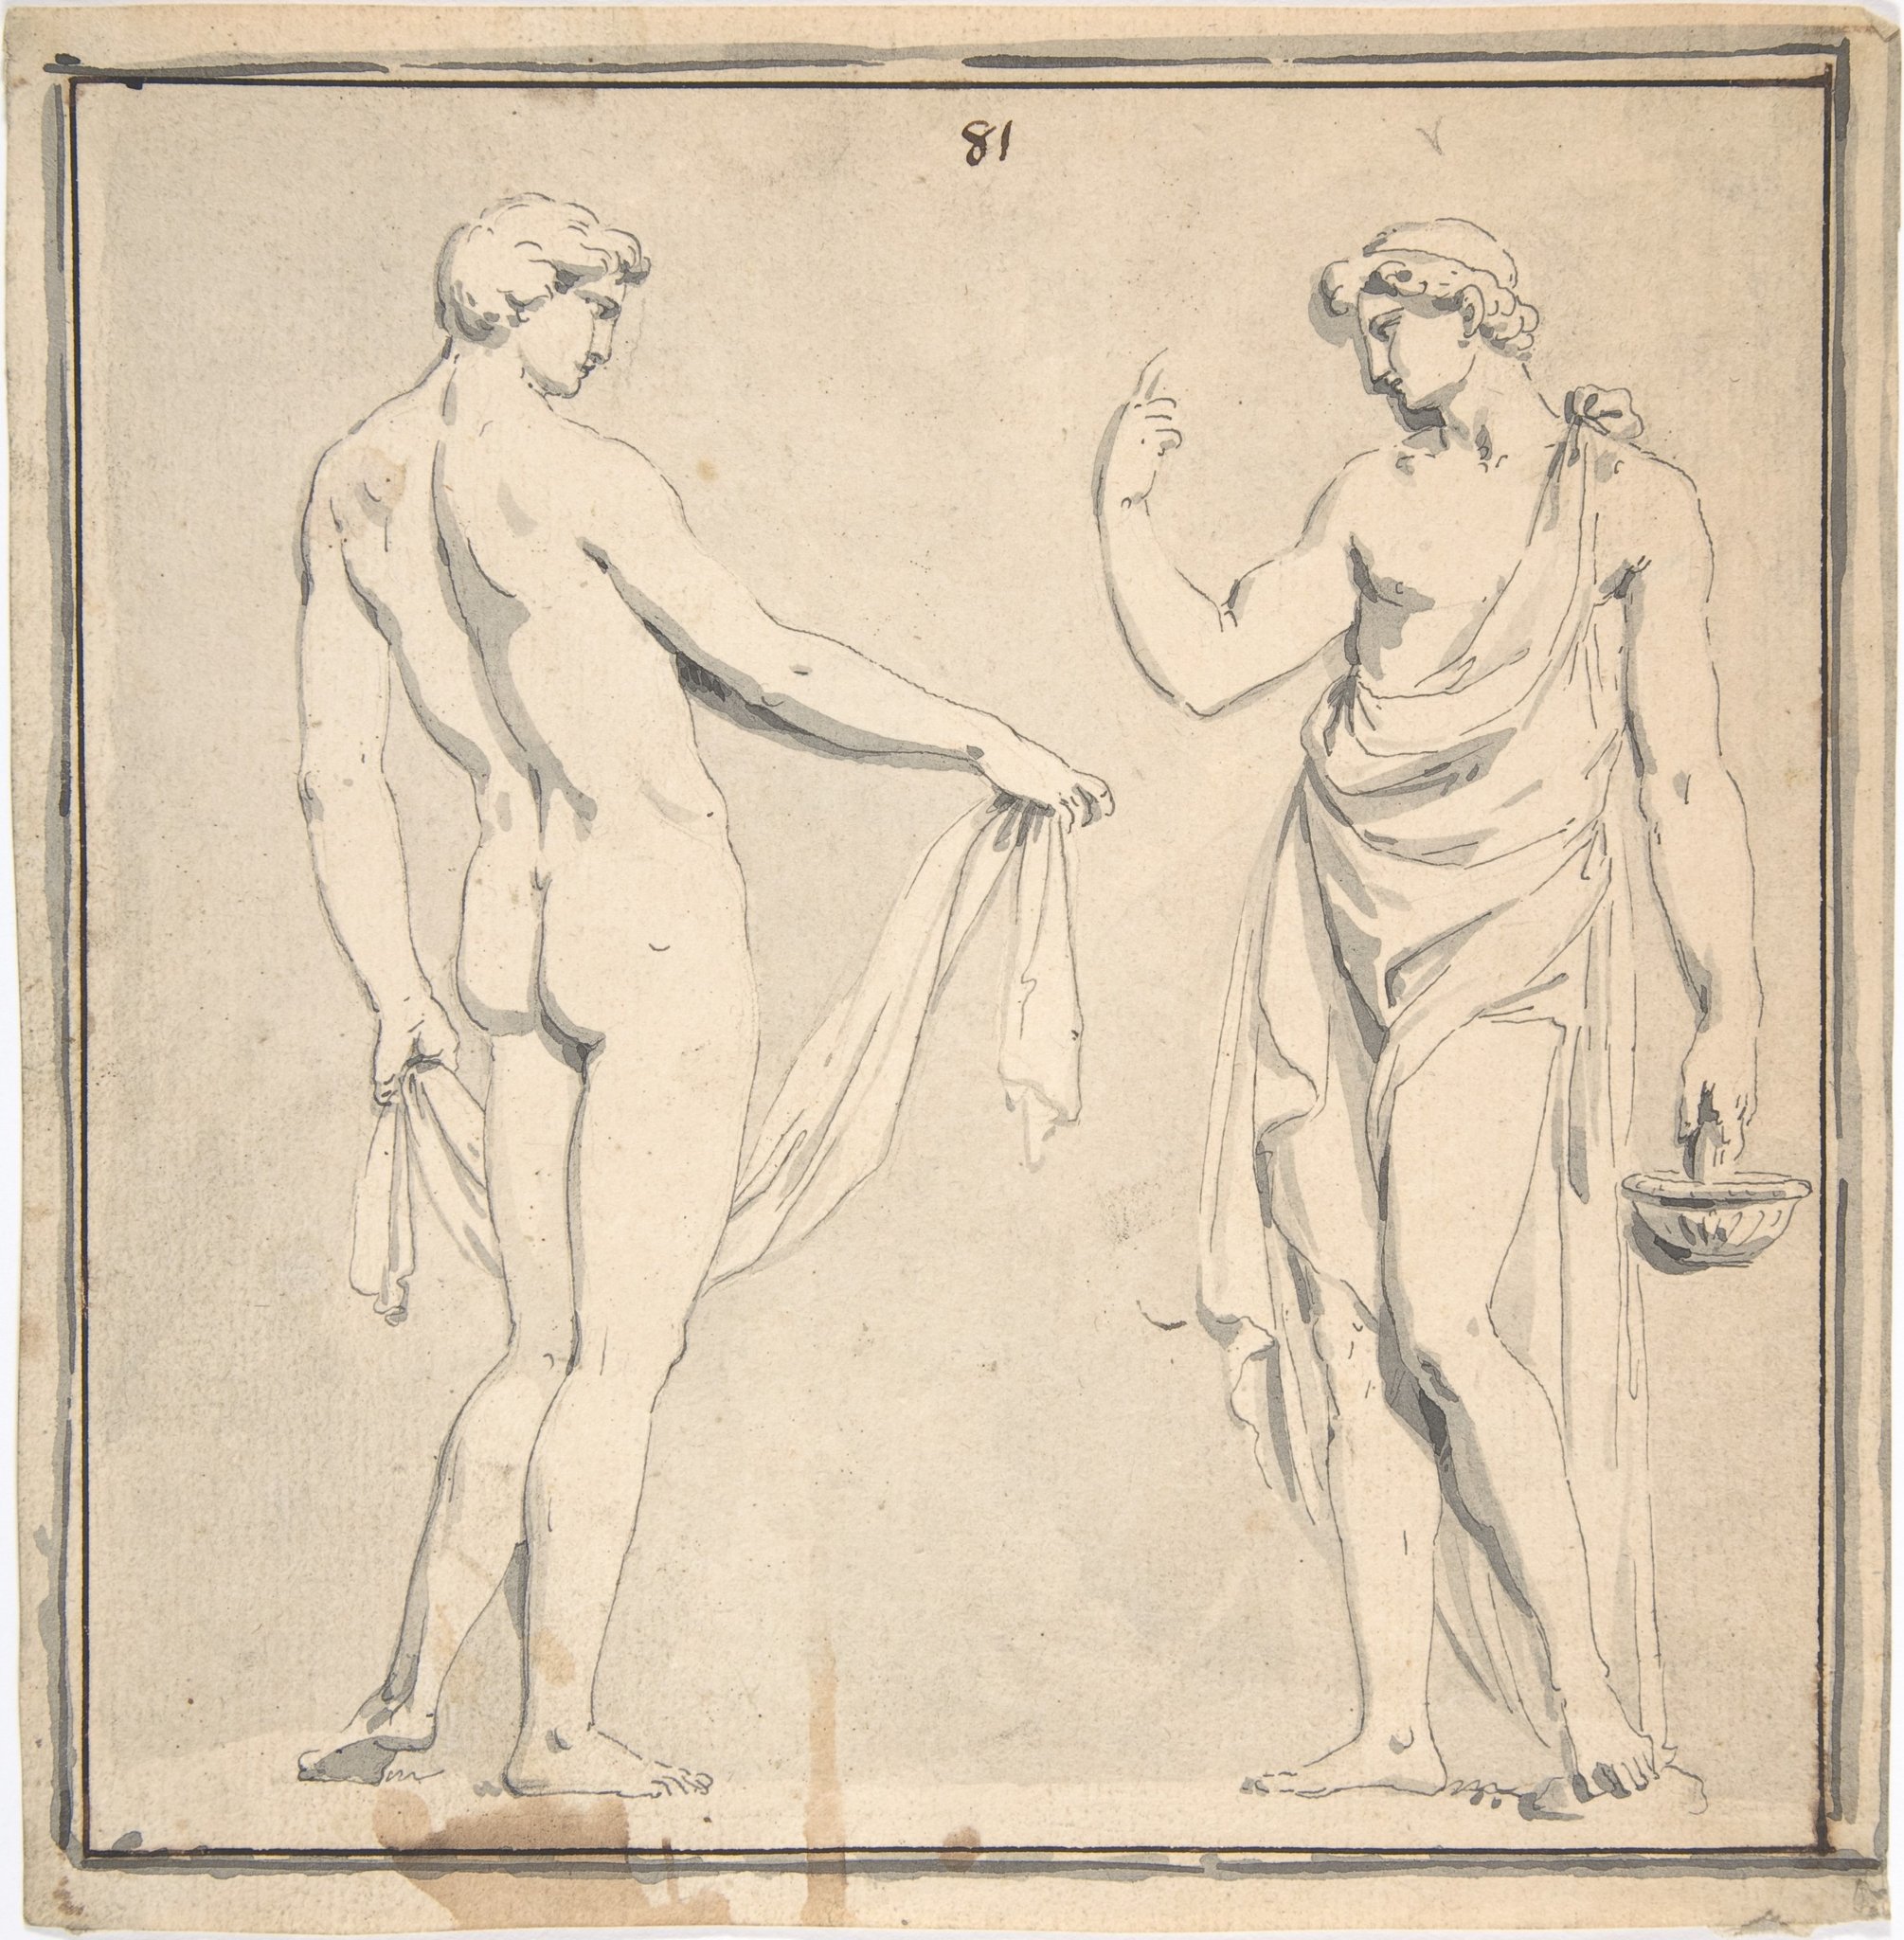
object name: drawing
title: Two Male Figures, one holding a basket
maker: anonymous, french, 18th century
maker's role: artist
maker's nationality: french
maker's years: 1700-1800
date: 1701-1800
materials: graphite, ink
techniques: brush, pen, wash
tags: men,male nudes